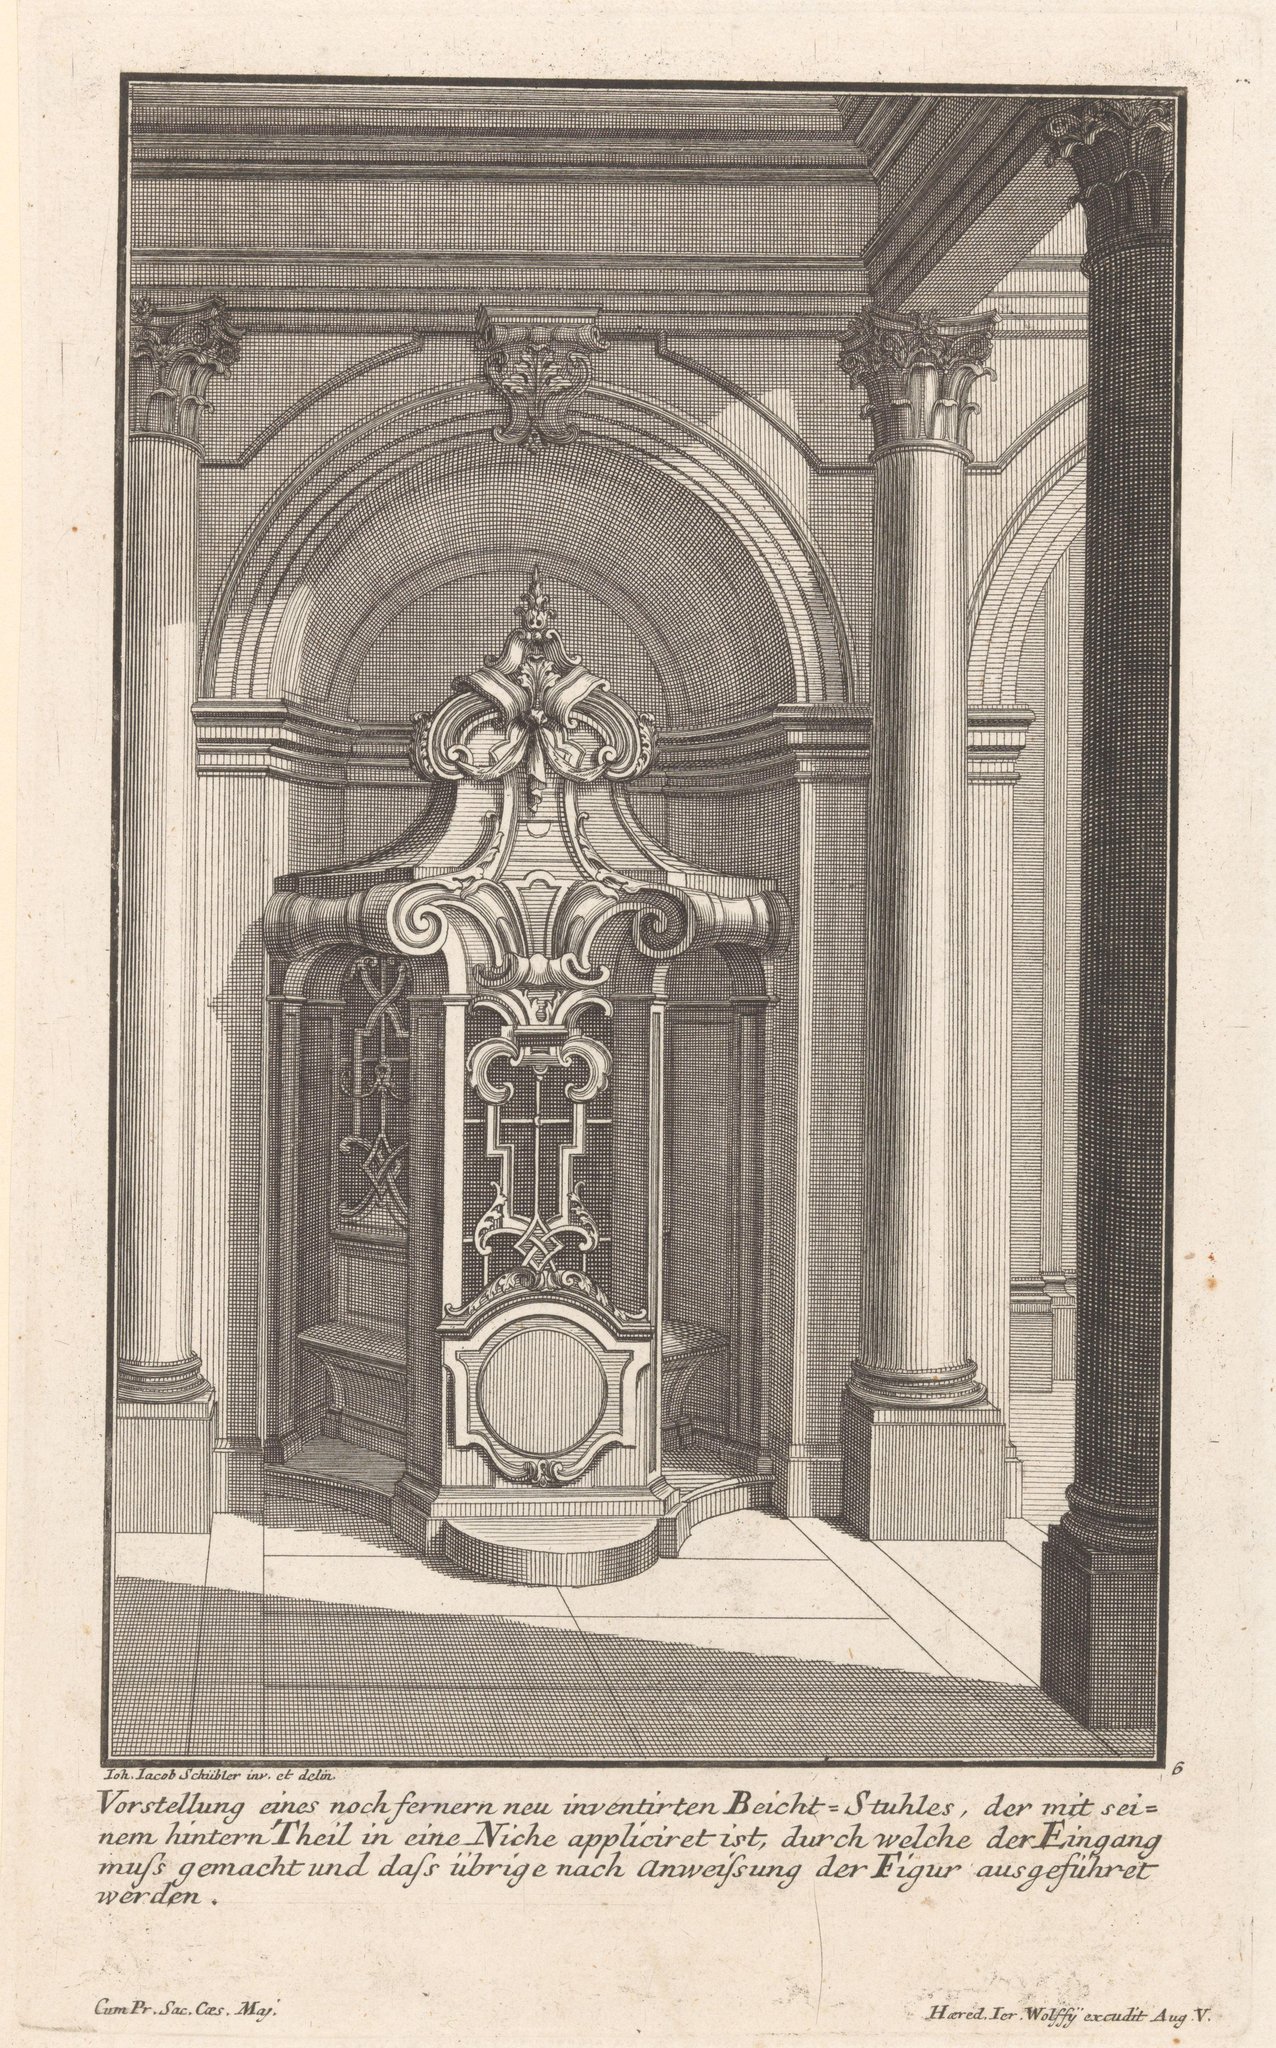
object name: ornament print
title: Johann Jacob Schüblers Zwölffte Ausgabe seines vorhabenden Wercks, Worinnen vorgestellet werden Neu-inventirte Confessioneaux oder Beicht-Stühle (...)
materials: paper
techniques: engraving, etching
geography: nuremberg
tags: rocaille ornament, 'concha' ~ architecture, confessional ~ part of the confession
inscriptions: collector's mark: Lugt 2228, collector's mark: Lugt 2760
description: Prent uit: Schübler, Johann Jacob. Erste [-Zwanzigste] Ausgabe seines vorhabenden Wercks (...). Augsburg: Wolf, erven Jeremias, [na 1724]